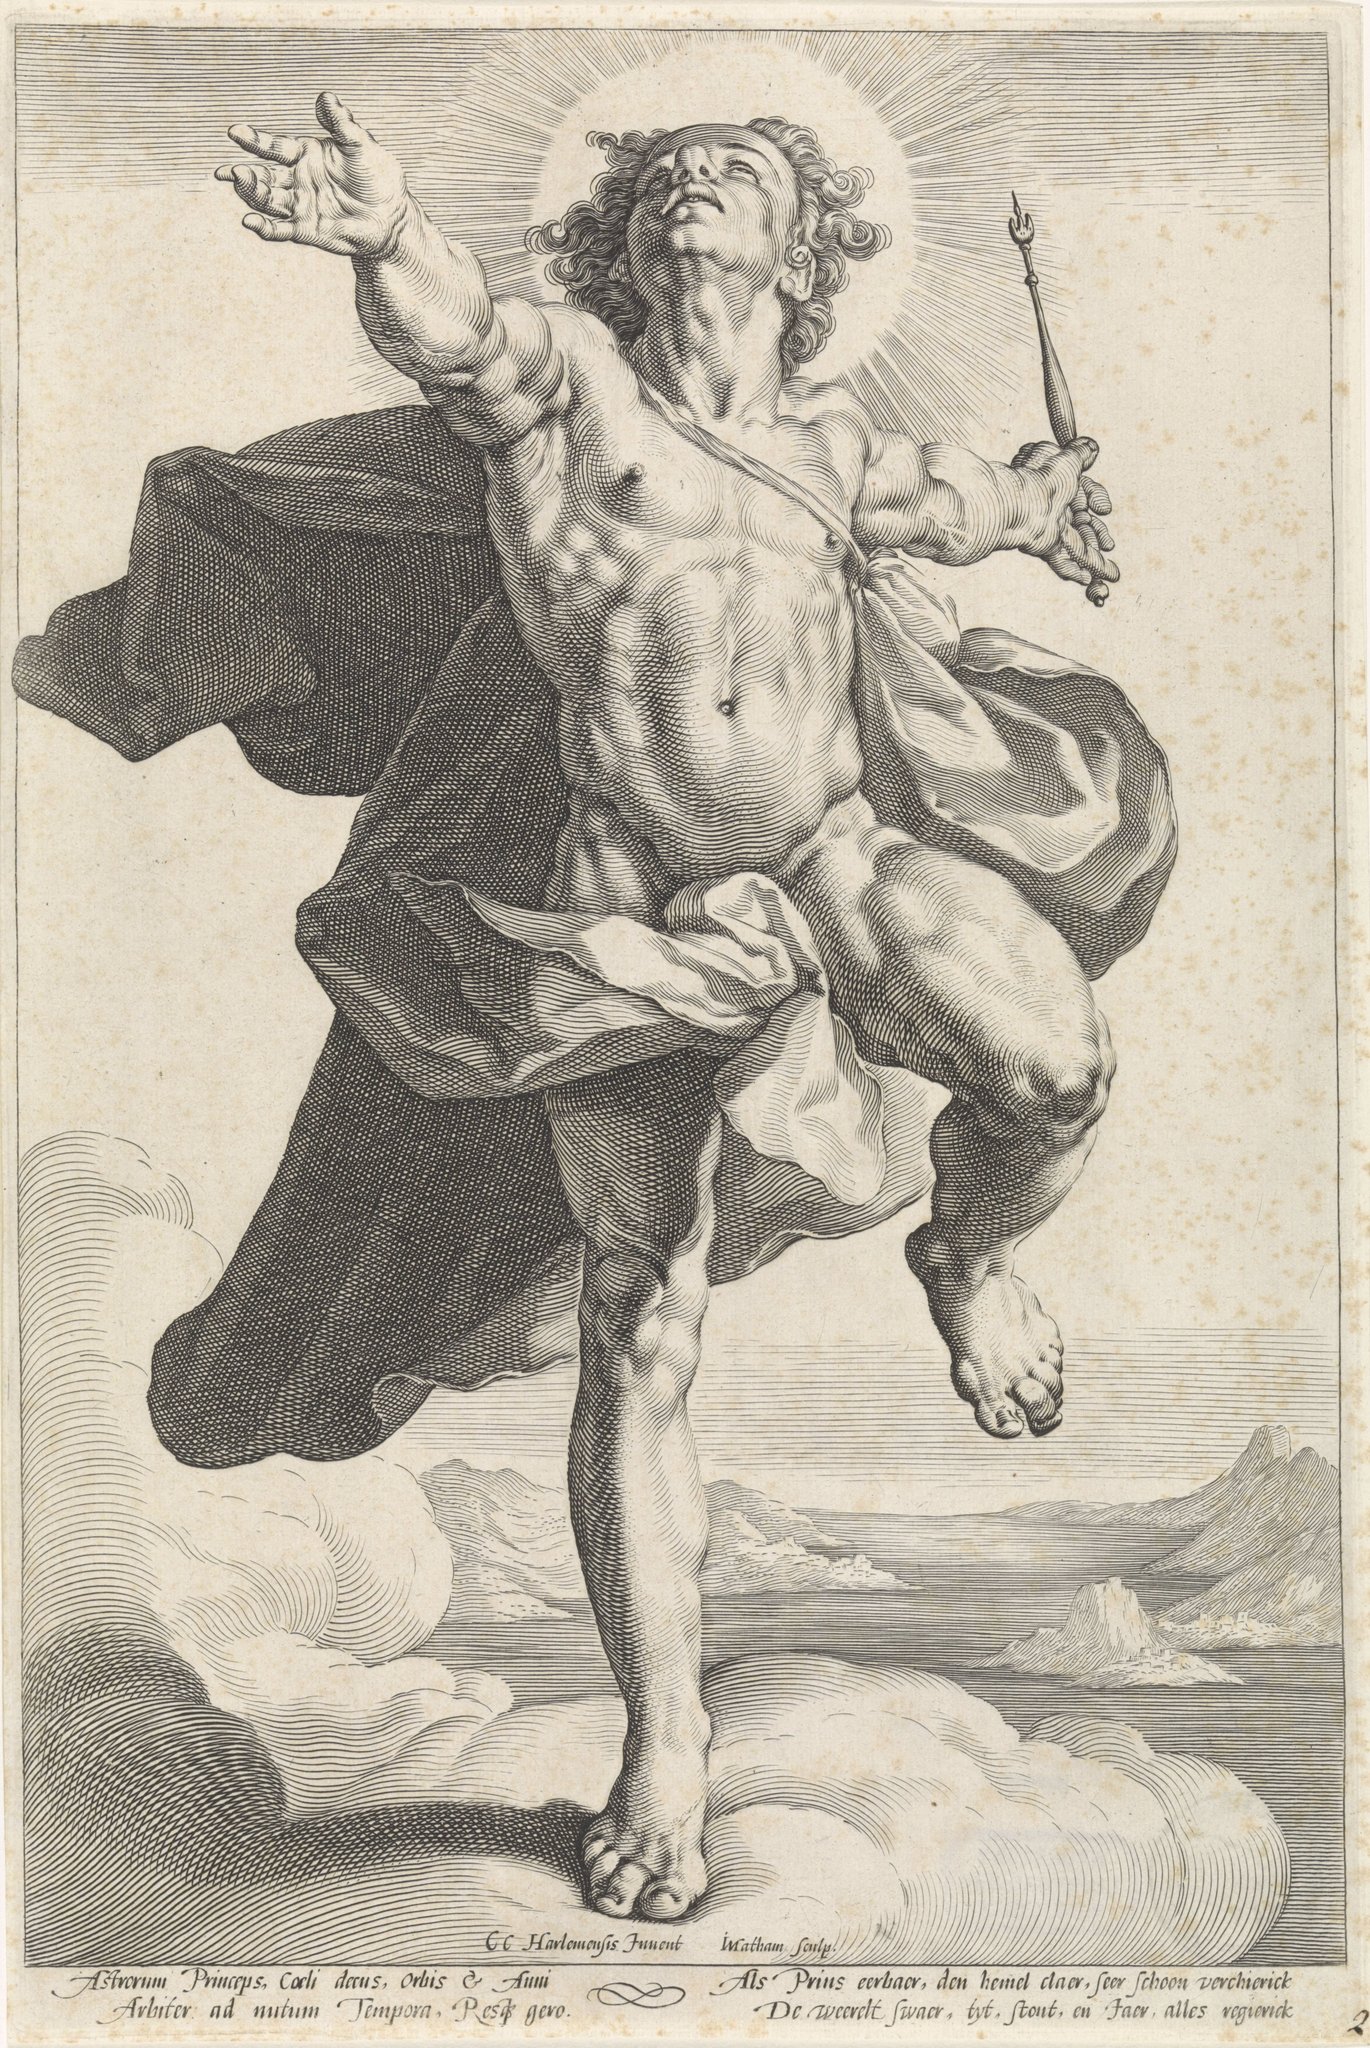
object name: print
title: Diana en Apollo als Luna en Helios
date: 1589-1593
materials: paper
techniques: engraving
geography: haarlem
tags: apollo as sun-god, i.e. sol (helius), titan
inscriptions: collector's mark: Lugt 11, collector's mark: Lugt 10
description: Apollo als de zonnegod Helios (Sol). Pendant van Diana als de maangodin Luna.